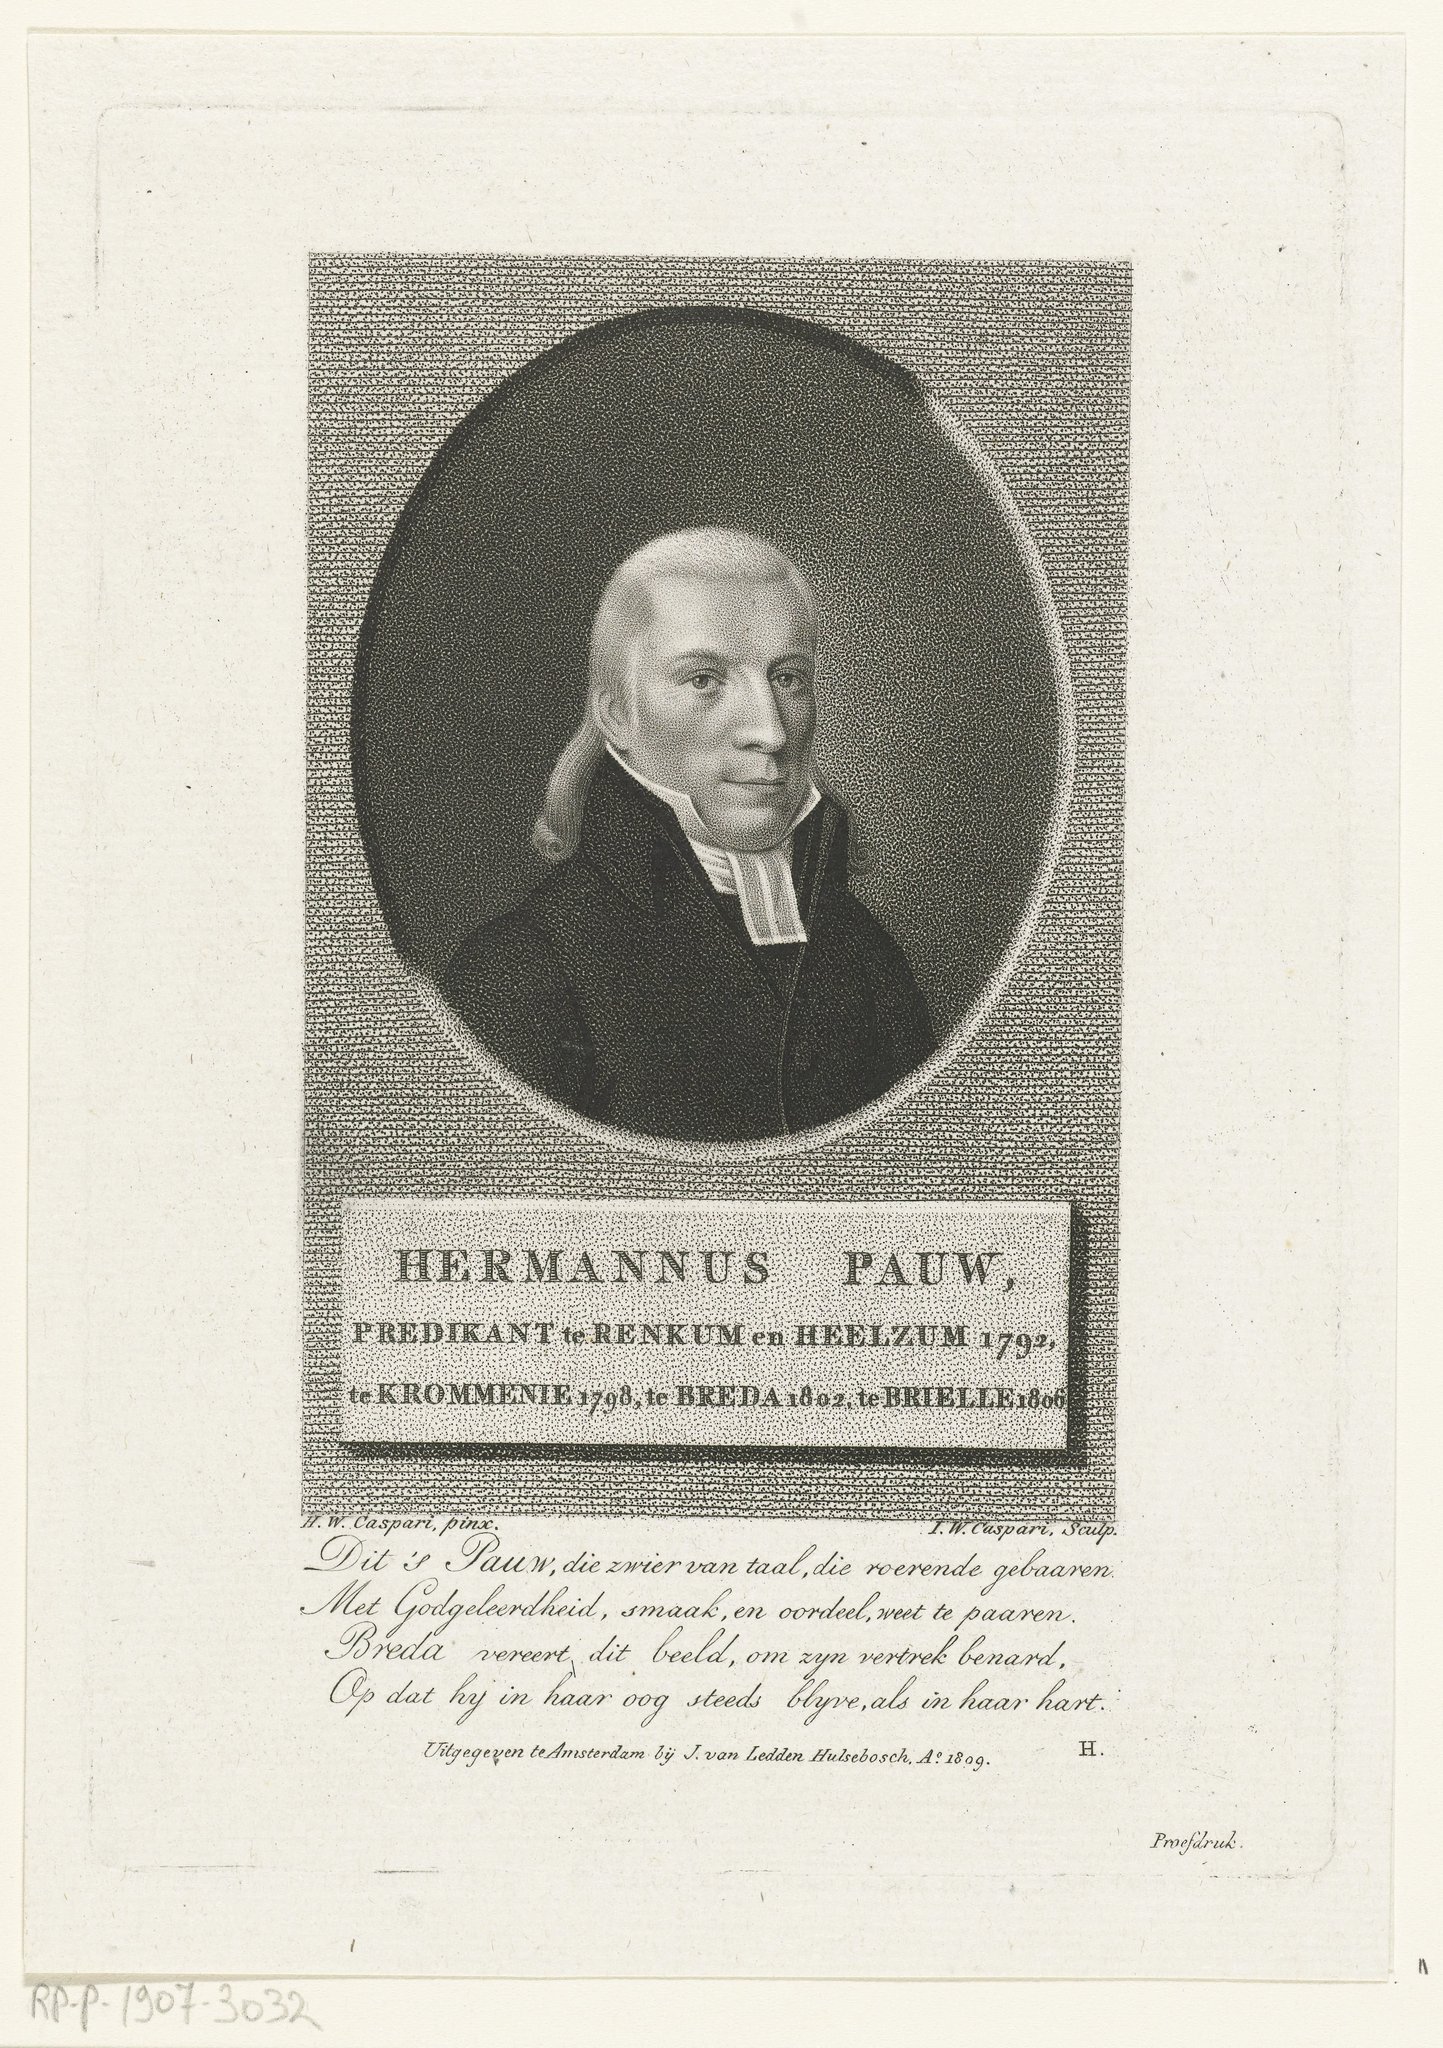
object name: print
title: Portret van Hermannus Pauw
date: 1809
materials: paper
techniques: etching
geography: amsterdam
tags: utrecht, hermannus pauw, historical persons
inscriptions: inscription: ‘proefdruk’, collector's mark: Lugt 2166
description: Rond portret van Hermannus Pauw, predikant van Renkum, Heelsum, Krommenie, Breda en Den Briel . Buste iets naar rechts. Pauw heeft een zwarte jas aan met een hoge kraag en een witte bef. De prent heeft een Nederlands gedicht als onderschrift